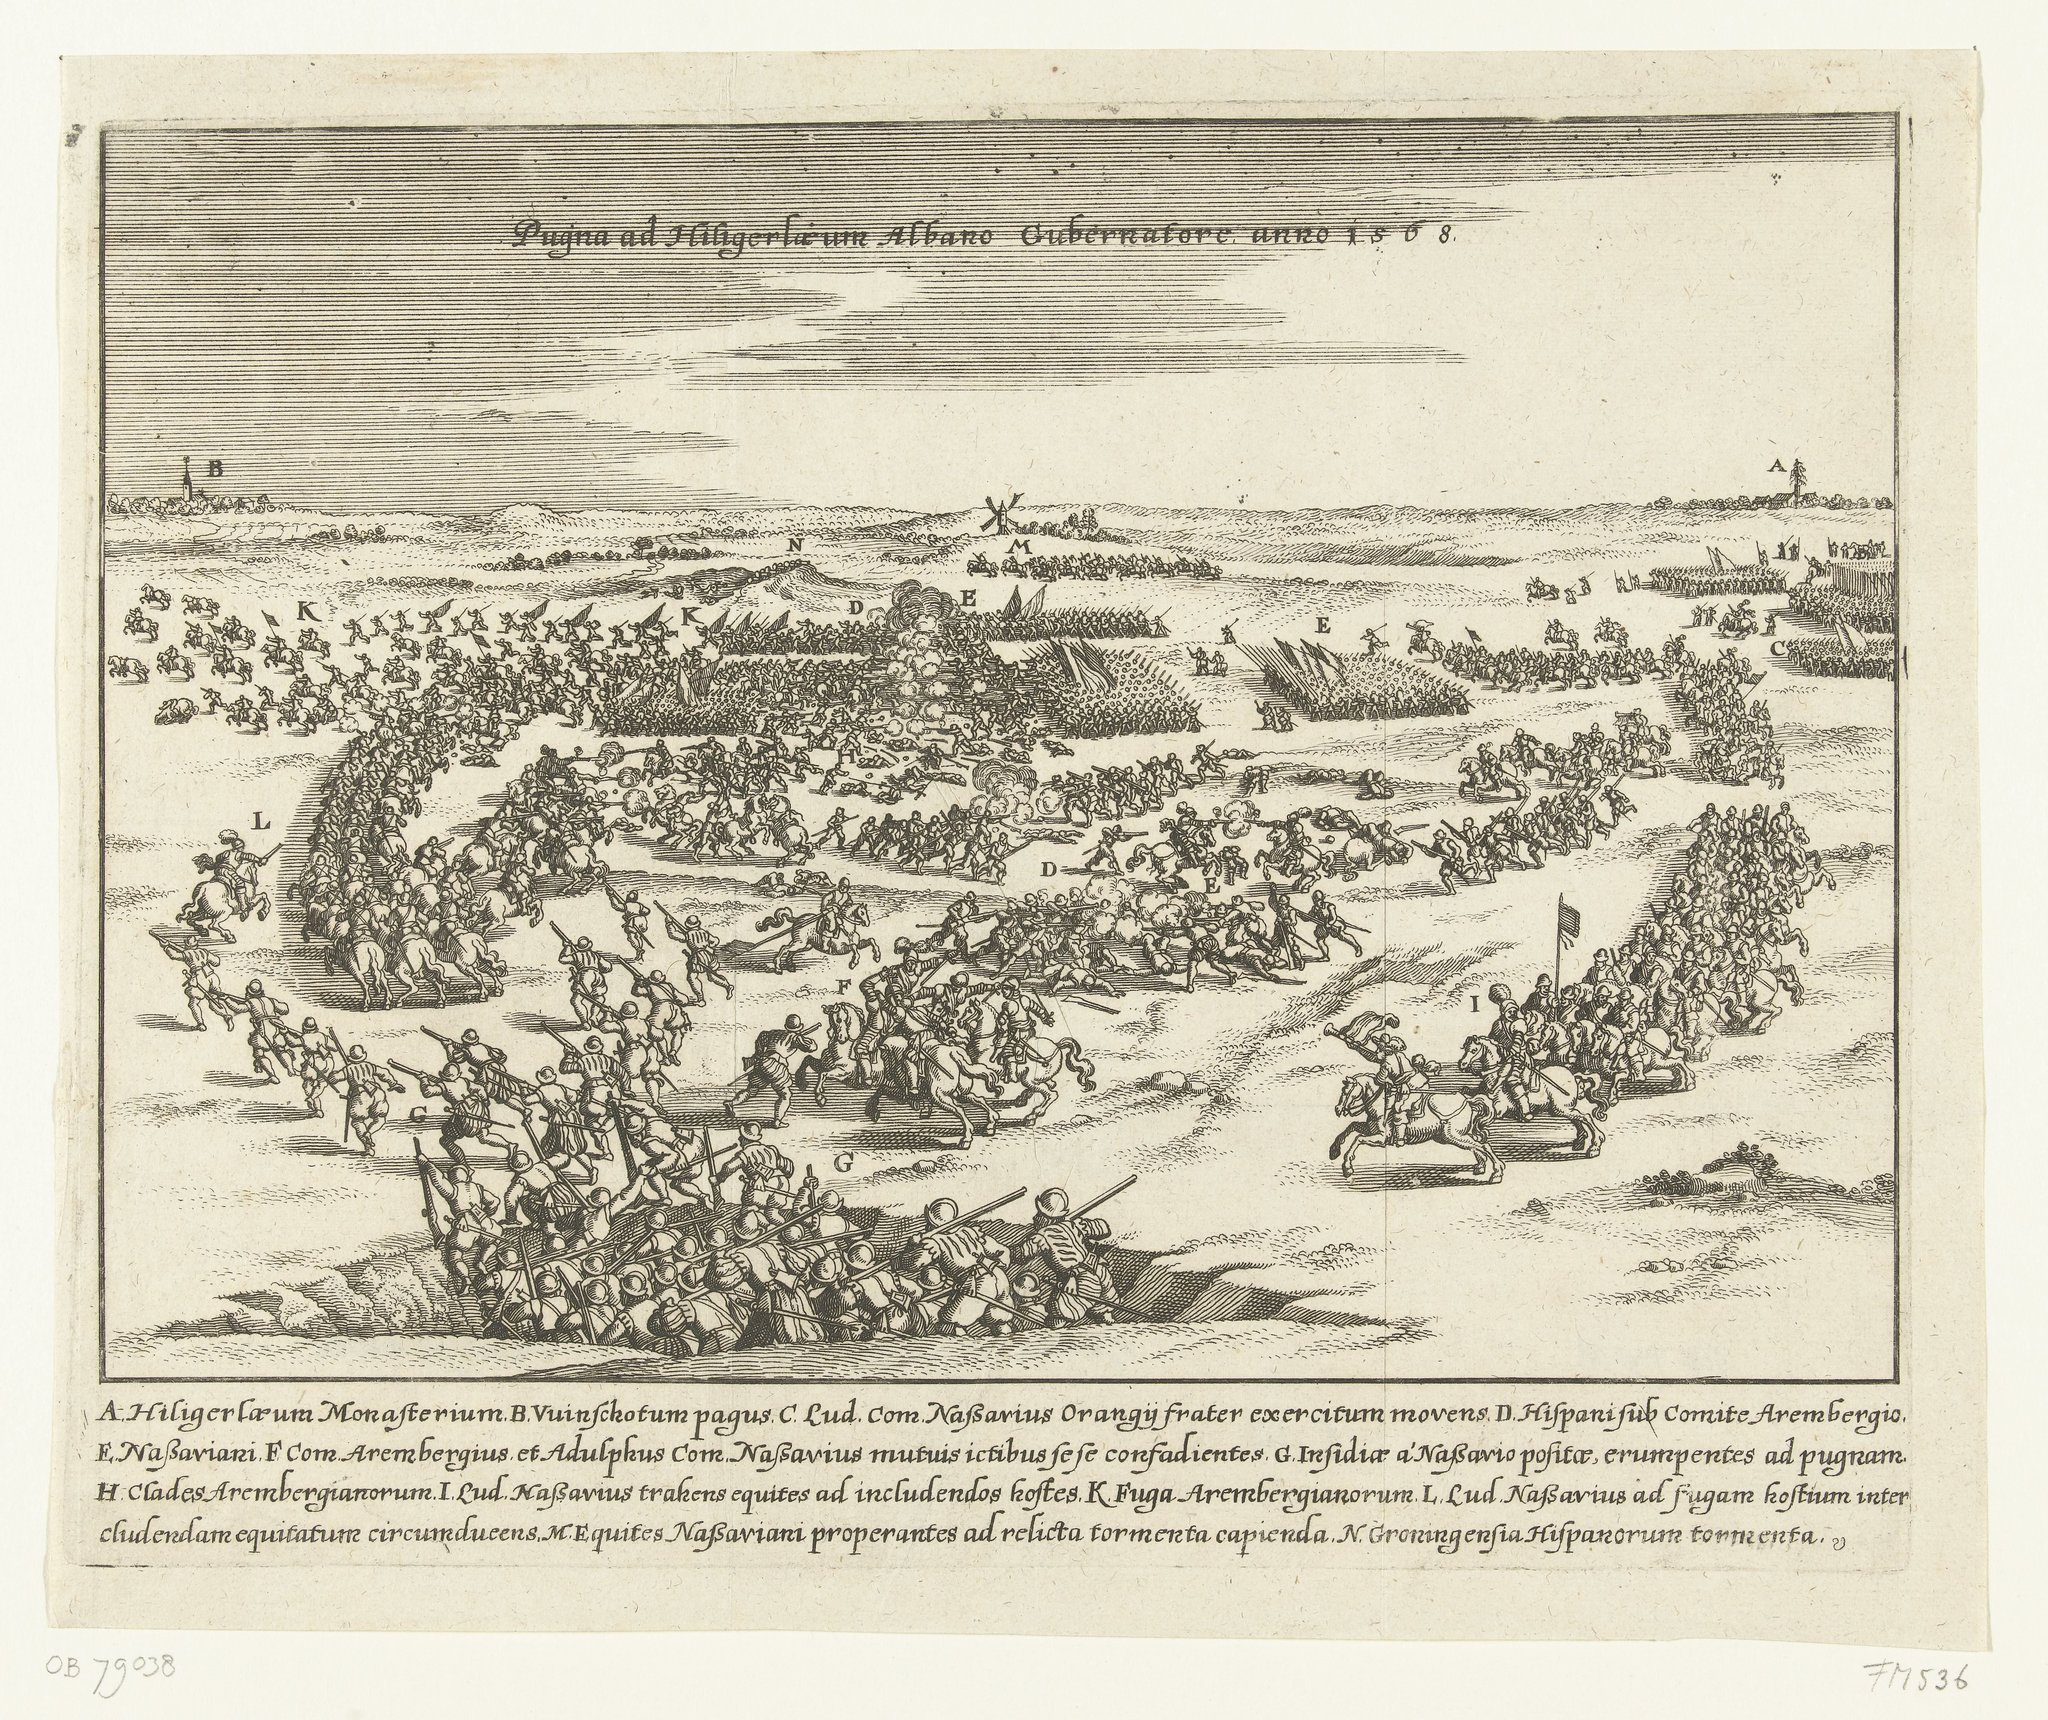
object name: print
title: Slag bij Heiligerlee, 1568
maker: Anonymous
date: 1649-1651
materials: paper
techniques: etching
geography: rome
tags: jean de ligne (duke of arenberg), battle (+ land forces)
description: Gebruikt als illustratie in: F. Strada, De Bello belgico decades duae auctiores et correctiores cum figuris encis prodeunt a Famiano Strada Soc: Jesu Romano Moguntiae 1651. Kopie naar de prent van J.W. Baur uit de oorspronkelijke editie van 1632, zie FMH 454A/3 en FMH 535A.